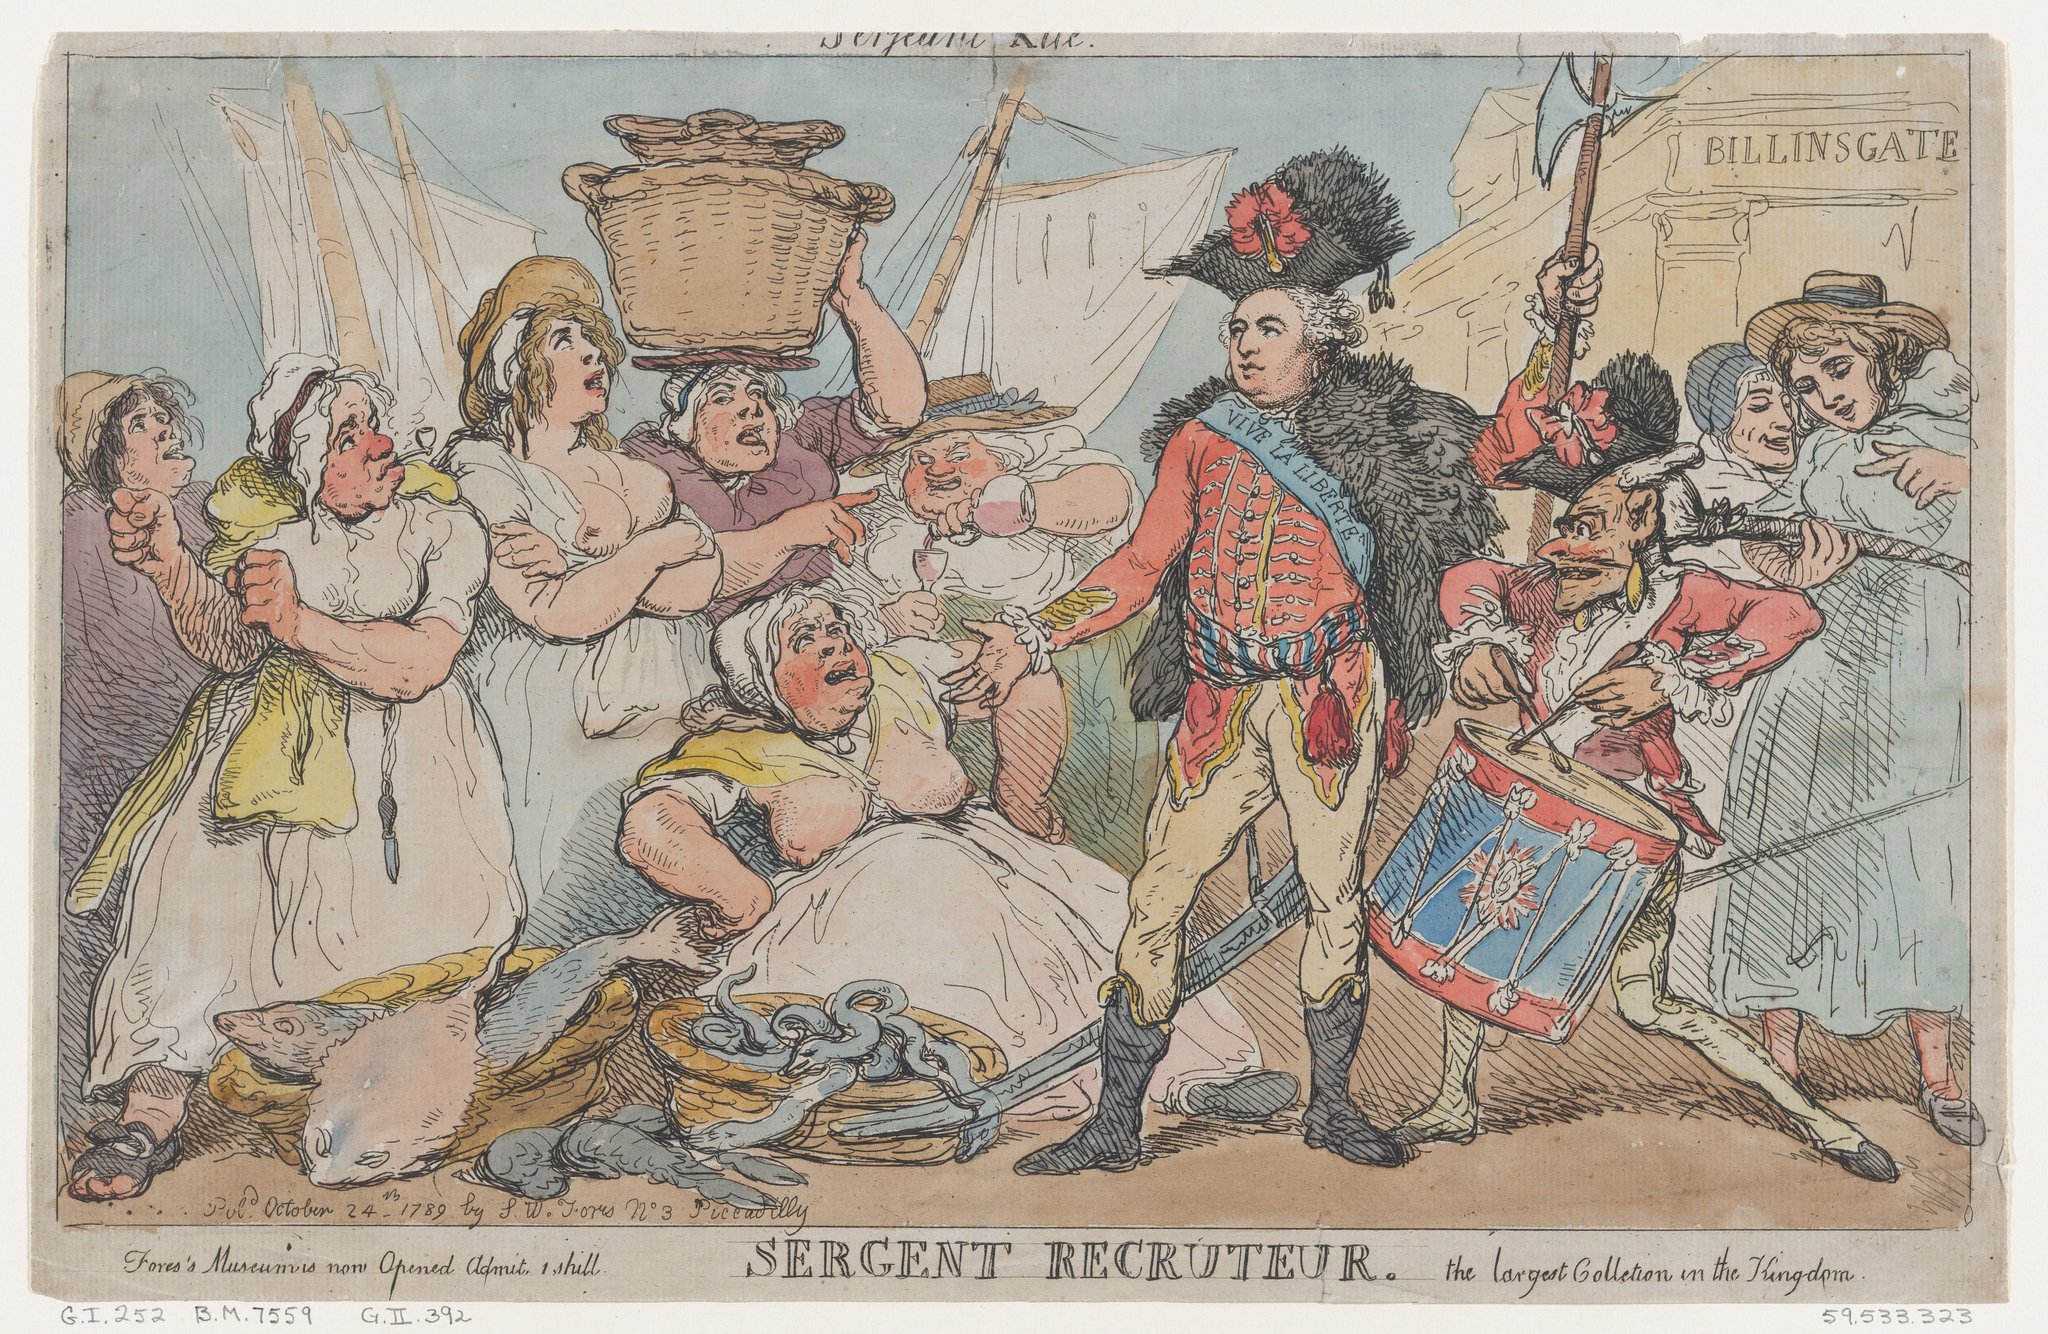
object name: print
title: Sergent Recruteur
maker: thomas rowlandson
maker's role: artist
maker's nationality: british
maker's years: 1757-1827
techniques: etching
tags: men,women,female nudes,drums,markets